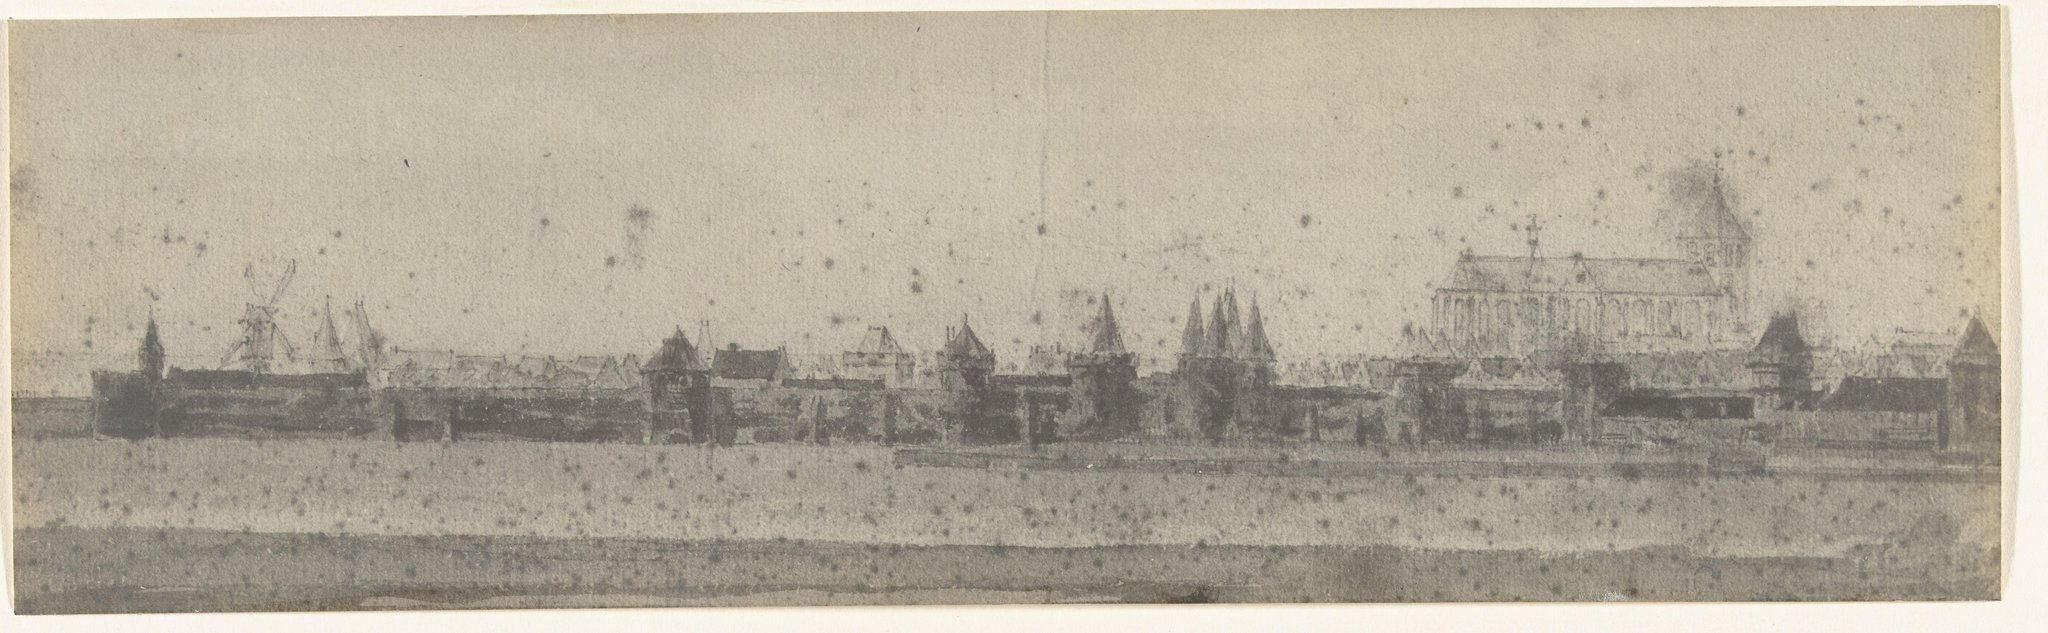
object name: photograph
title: Foto's van tekeningen van de Franse inval in de Nederlanden in 1672 door Adam Frans van der Meulen bewaard in de Manufacture des Gobelins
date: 1900-1903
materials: paper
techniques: gelatin silver print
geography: france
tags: lodewijk xiv (koning van frankrijk), prospect of city, town panorama, silhouette of city, den bosch, rampjaar (disaster year)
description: Niet in Frederik Muller; door het RPK toegevoegd nummer. Onderdeel van een groep van ca. 50 foto's van tekeningen van de Franse inval in de Nederlanden in 1672 door Adam Frans van der Meulen, bewaard in de Manufacture Nationale des Gobelins te Parijs.